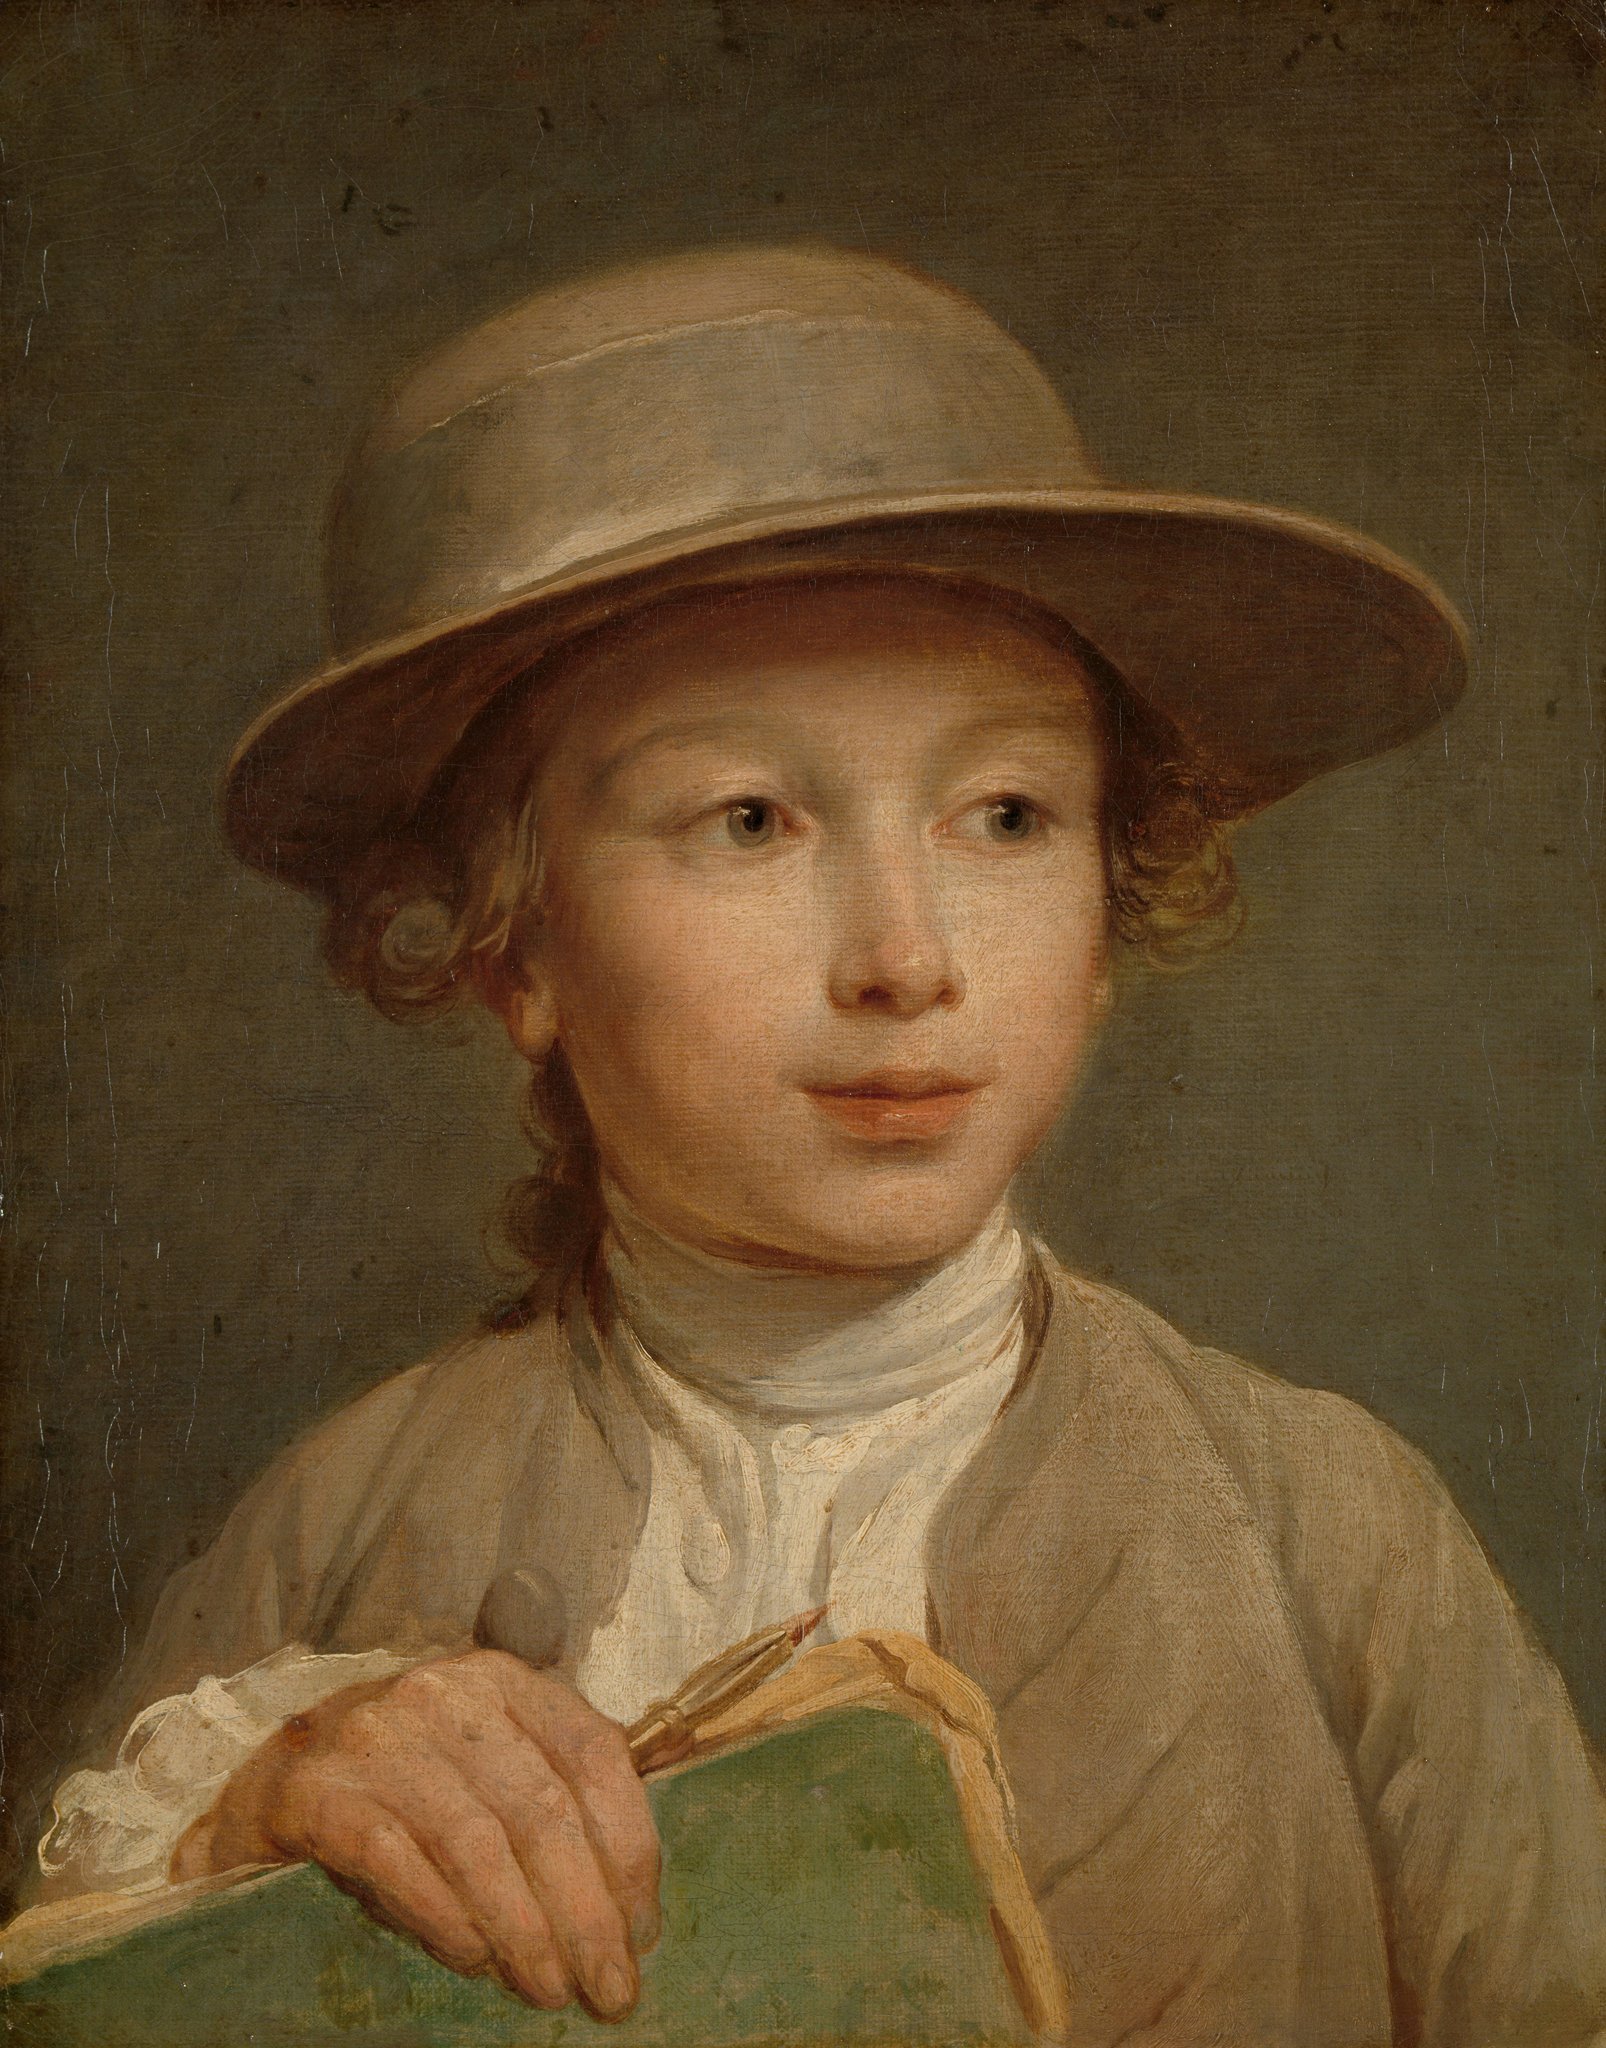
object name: painting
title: Boy with a Drawing Book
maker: nicolas bernard lépicié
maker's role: painter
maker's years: 1735-1784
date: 1772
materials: canvas, oil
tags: boy (child between toddler and youth), book, anonymous historical person portrayed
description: This is typical of the ‘sentimental’ studies of children that found such favour in France during the second half of the 18th century. It may be a portrait of a pupil or child of the artist. The painting is still in its original 18th-century frame.